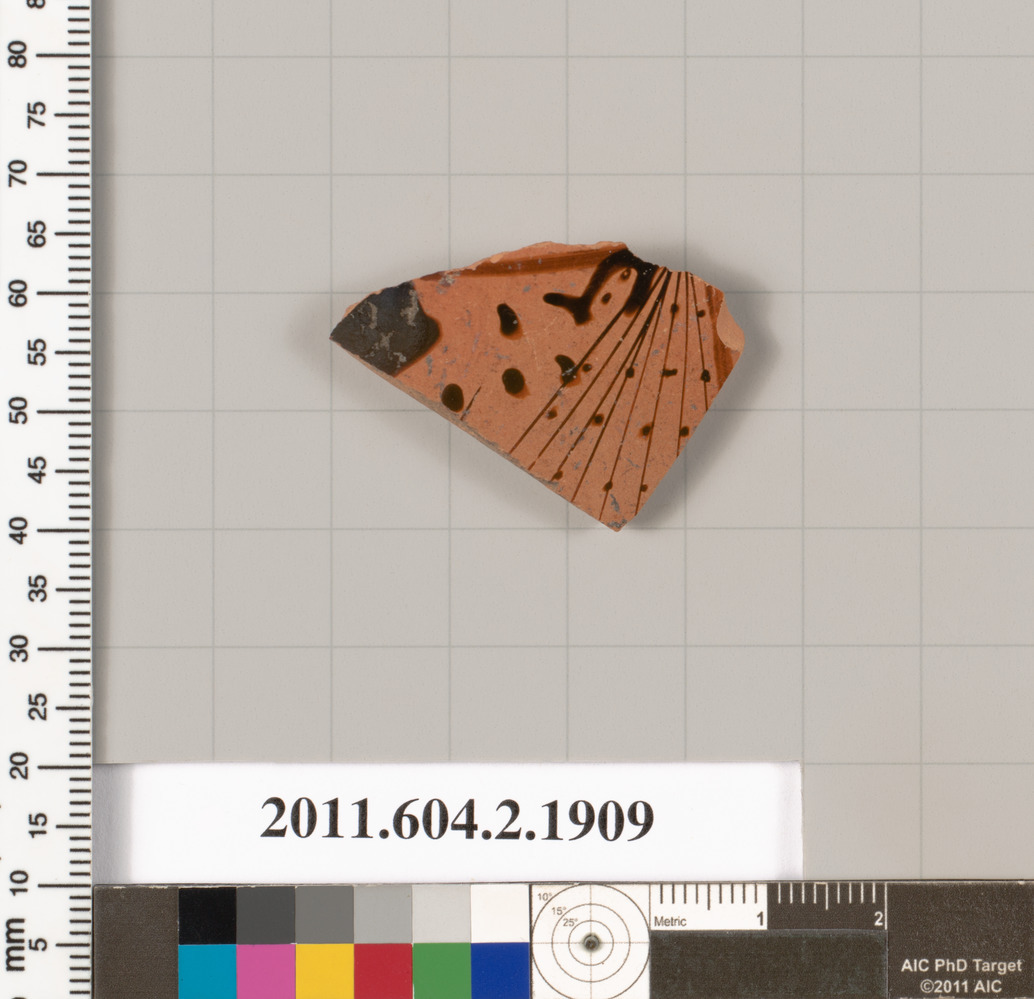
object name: skyphos fragment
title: Terracotta fragment of a skyphos (deep drinking cup)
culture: greek, attic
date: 460-430 BCE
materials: terracotta